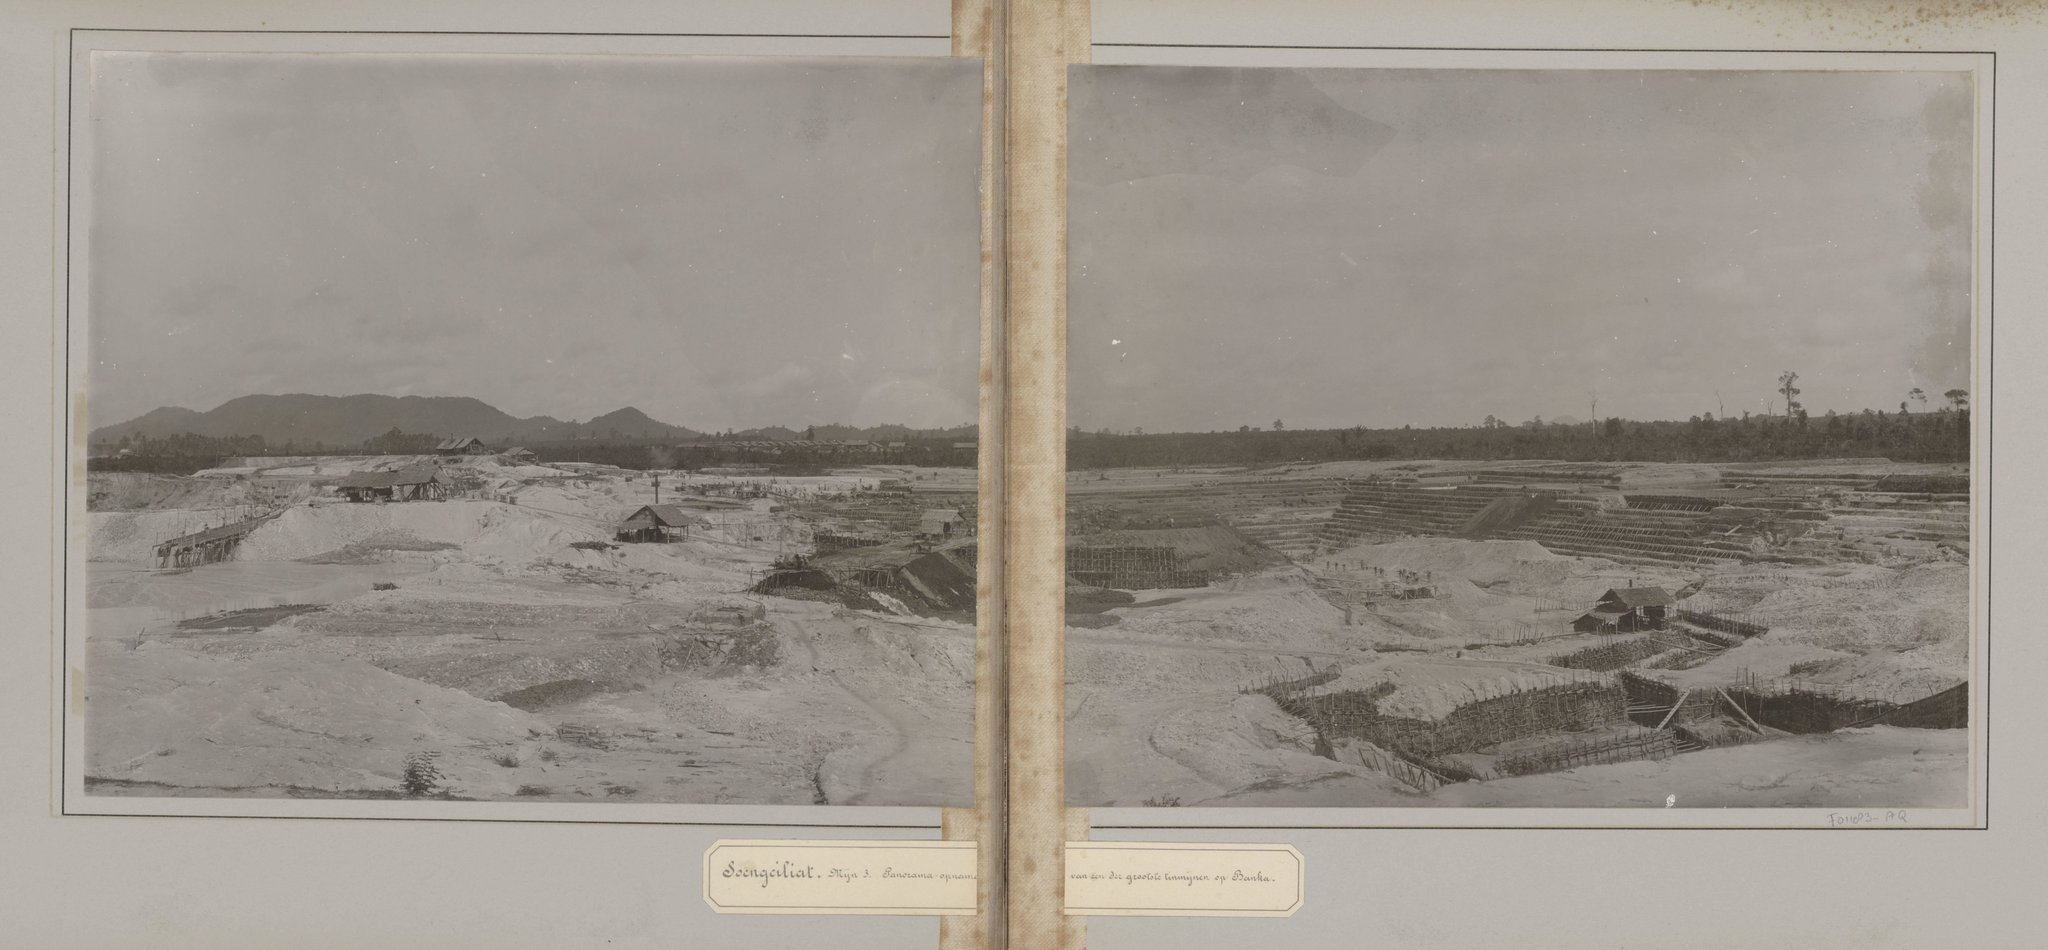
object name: panoramic photograph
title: Gezicht op een tinmijn te Soengeiliat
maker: Anonymous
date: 1900-1920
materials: photographic support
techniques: gelatin silver print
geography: soengeiliat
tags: mining, minerals and metals: tin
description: Panorama bestaande uit twee foto's. Onderdeel van Fotoalbum over de tinwinning op Bangka.